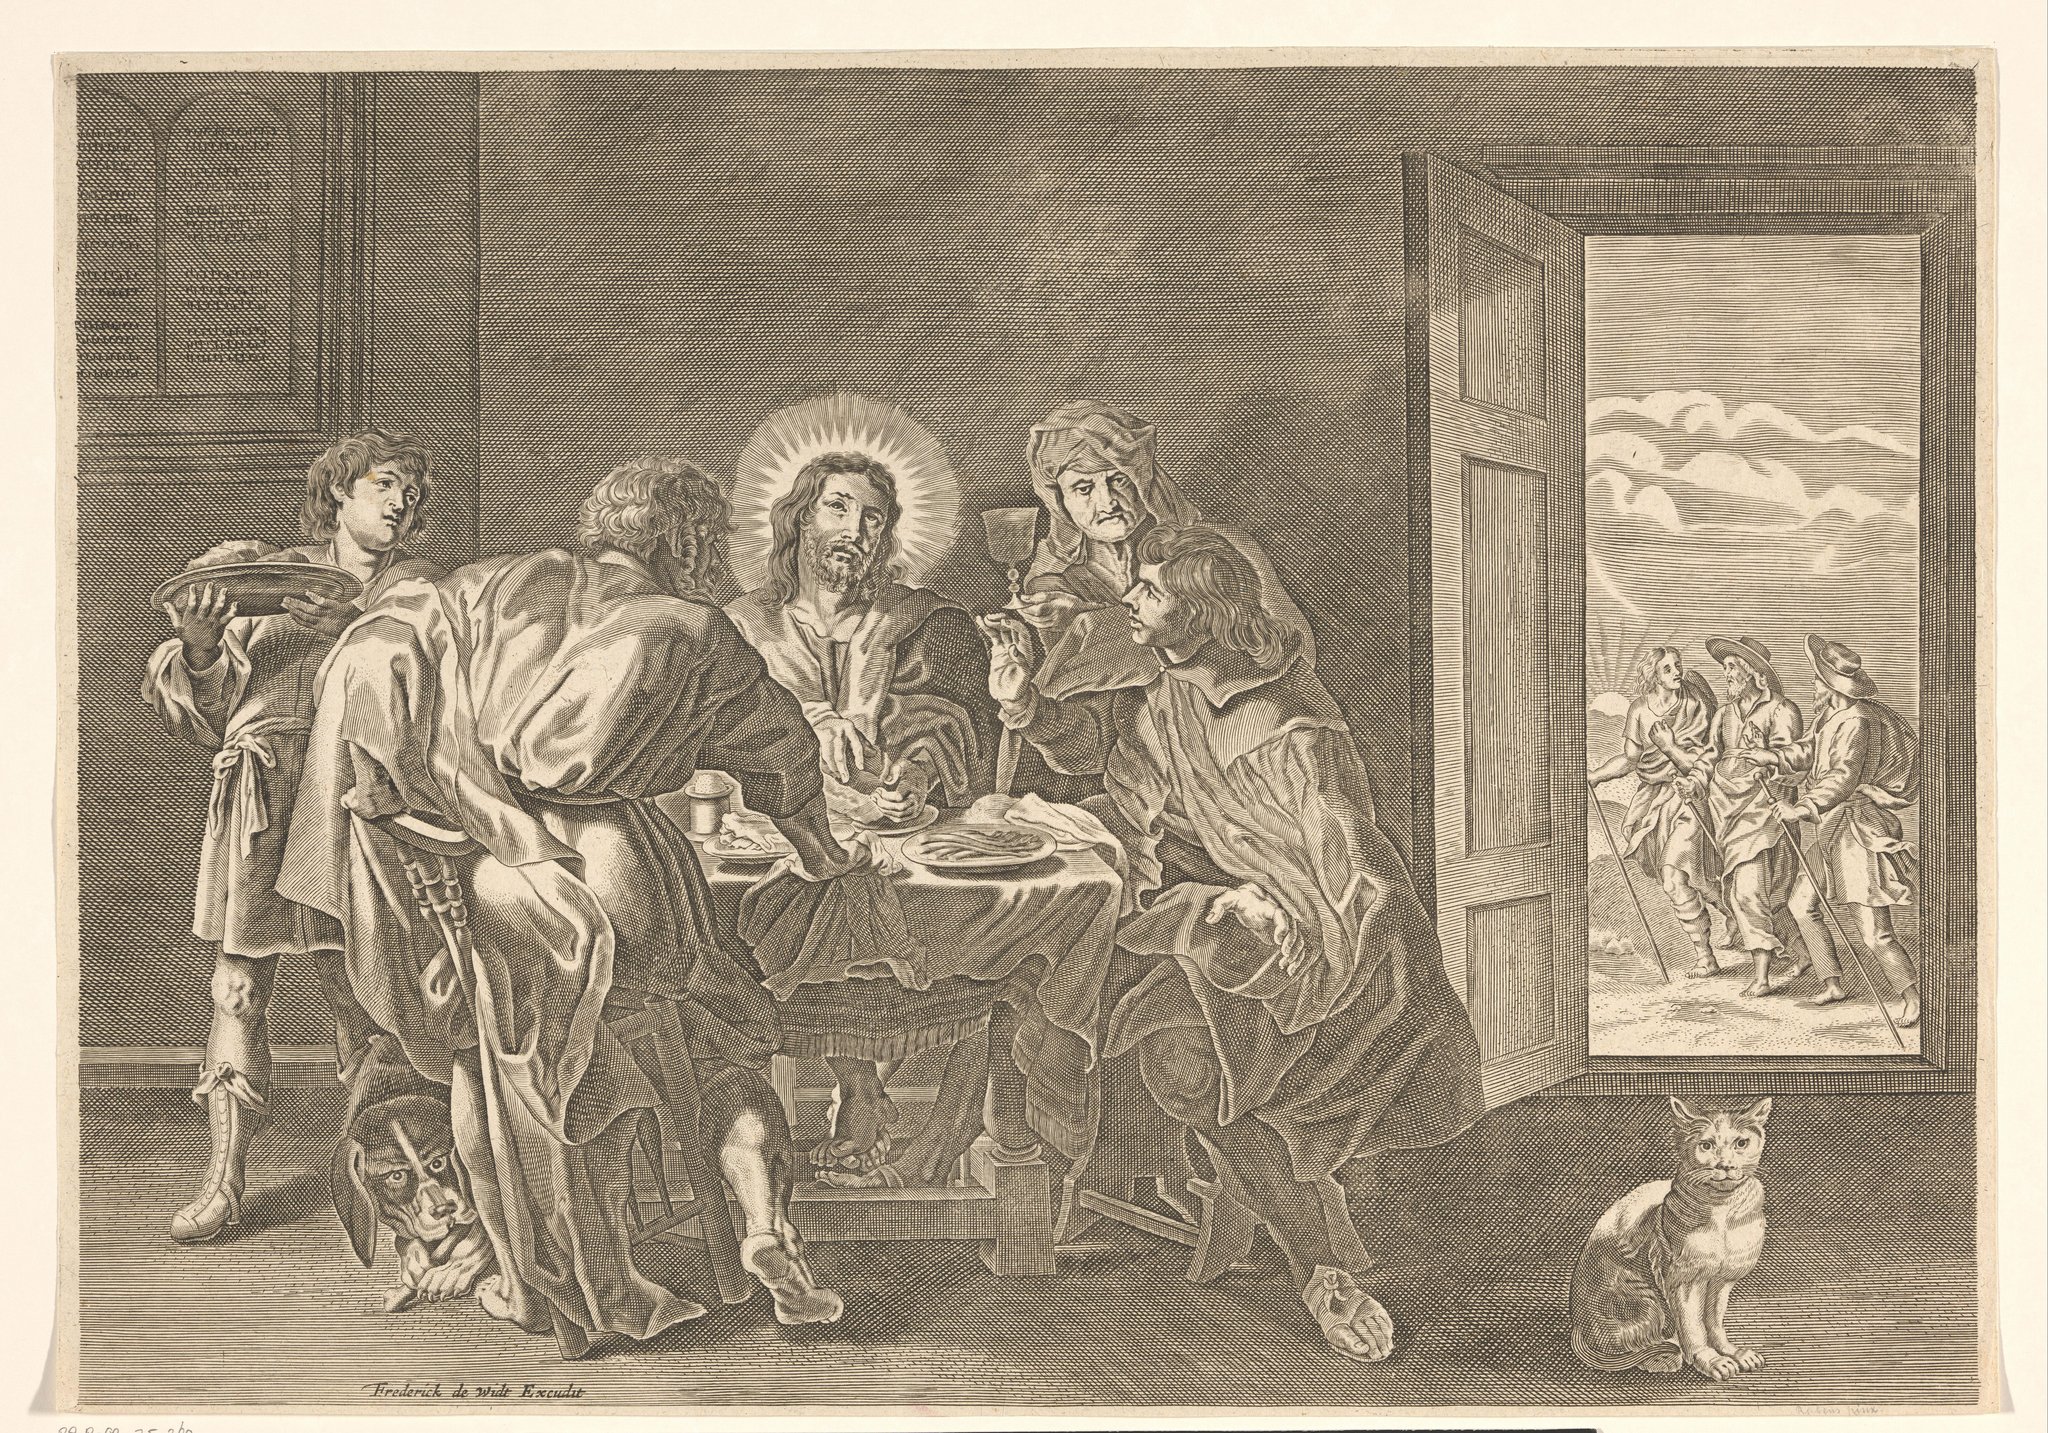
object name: print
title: Royaalbijbel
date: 1645-1706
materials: paper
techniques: engraving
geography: amsterdam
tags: the supper at emmaus: christ is recognized while blessing or breaking the bread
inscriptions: collector's mark: Lugt 240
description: Verschillende Amsterdamse uitgevers gaven vanaf de jaren ’30 van de zeventiende eeuw grote Bijbelse prenten op zogenaamd royaal-formaat papier (ca. 480 x 580 mm) uit. De uitgave van royaalbijbelprenten door de firma Visscher van Claes Jansz. Visscher (II), Nicolaes Visscher (I) en (II) is het meest bekend. Deze prent is gekopieerd naar de prent met hetzelfde thema, die werd uitgegeven door de firma Visscher. Vermoedelijk is deze prent ook als royaalbijbelprent uitgegeven. De voorstelling van de maaltijd in Emmaüs naar een prent van Swanenburg of Van Sompel naar een schilderij van Rubens. De Emmaüsgangers in de deuropening naar een anonieme prent naar ontwerp van de Vos.